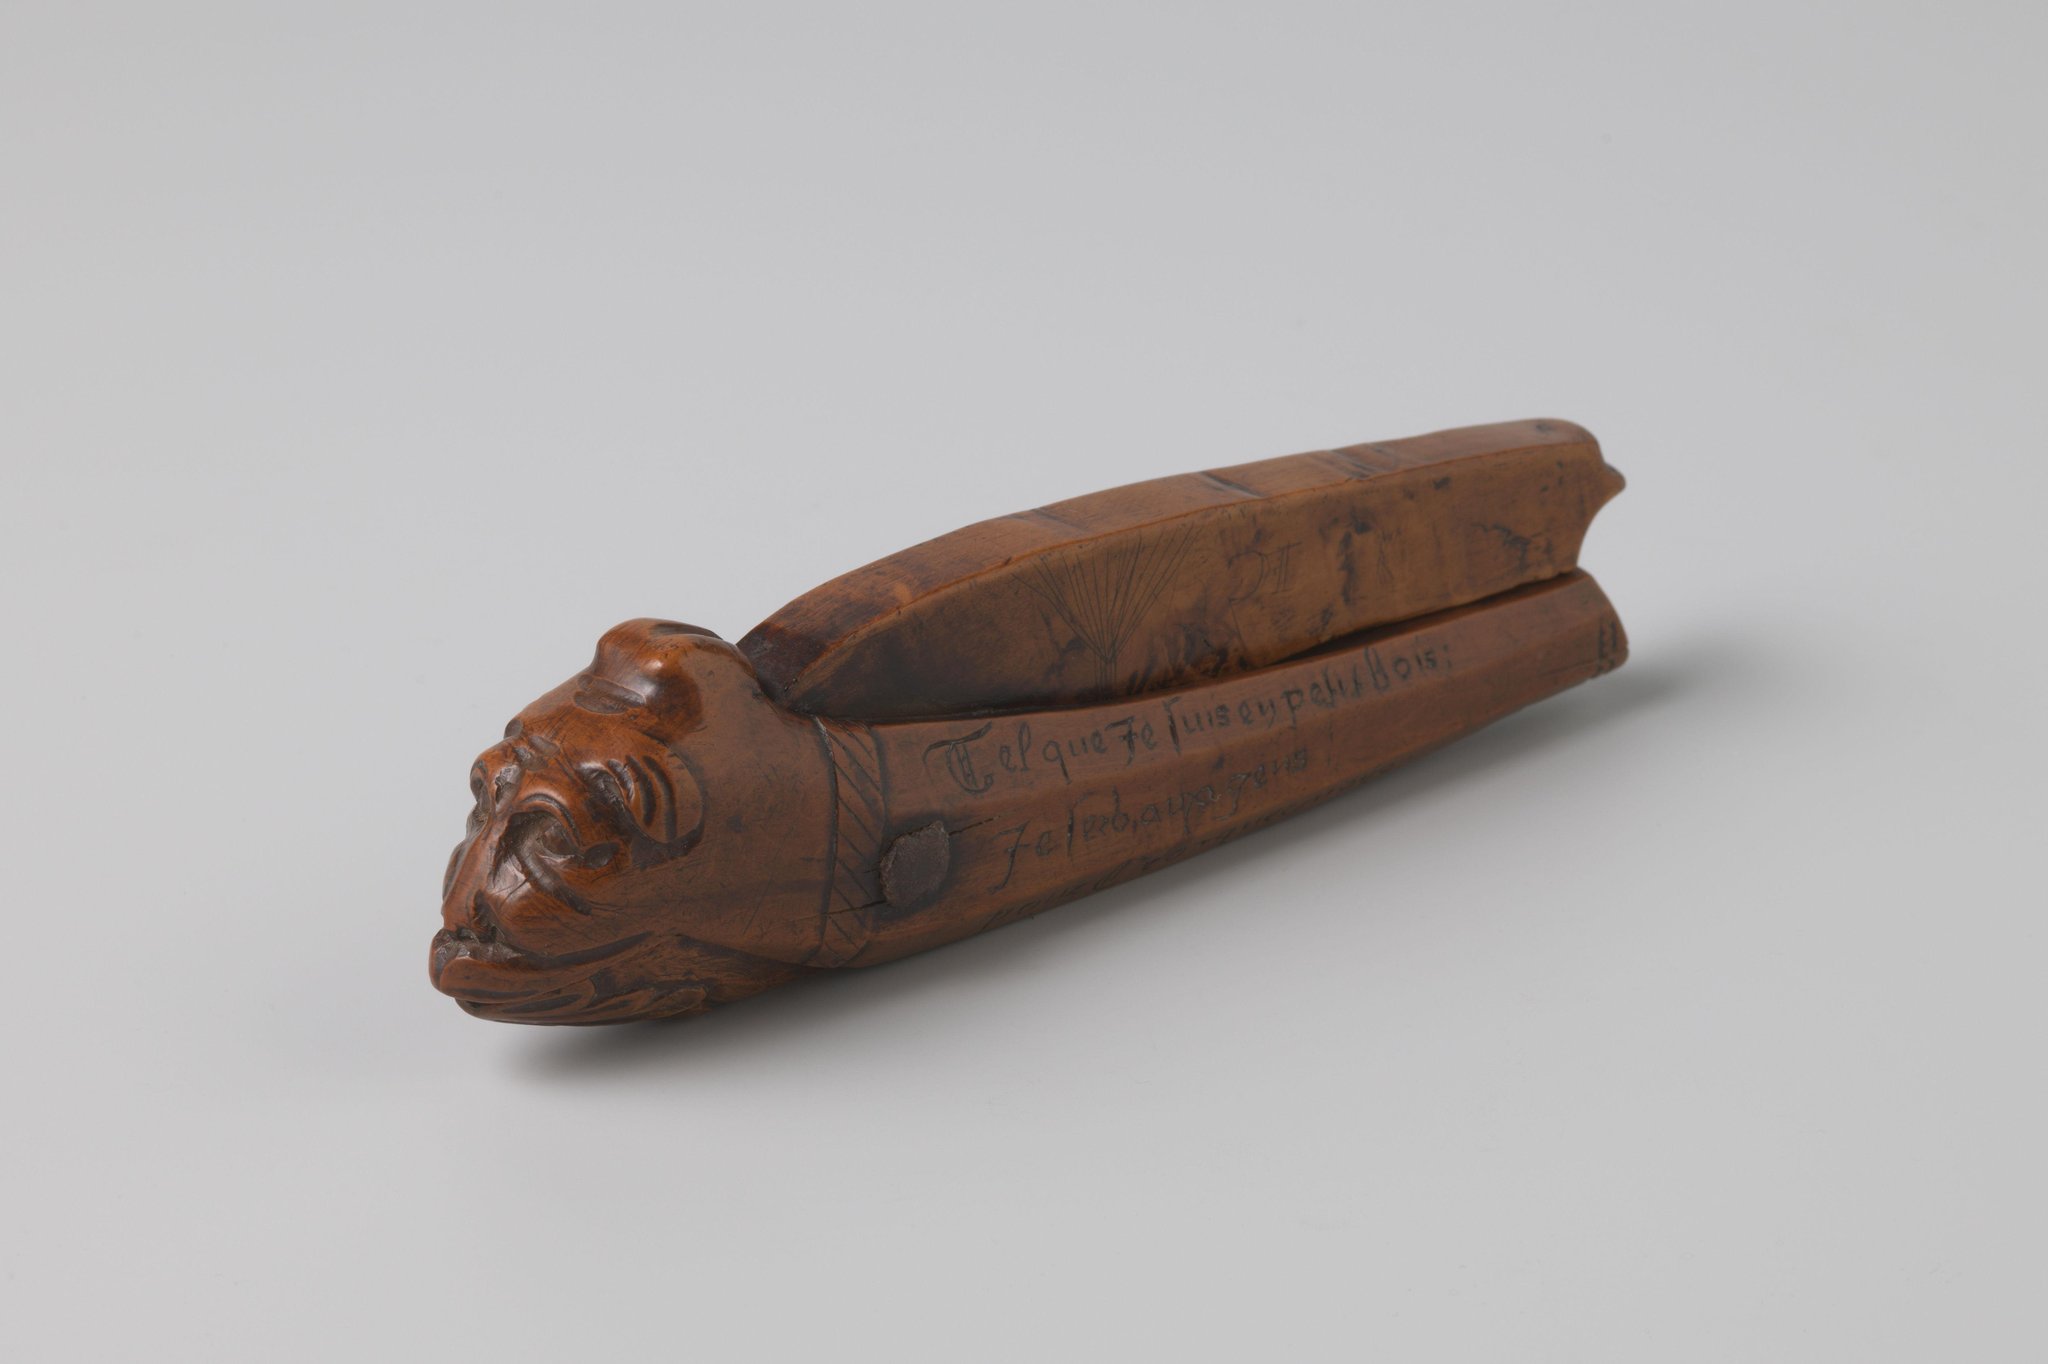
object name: nutcracker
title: Notenkraker van palmhout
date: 1583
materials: wood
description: Gesneden in de vorm van een beestenkop met inscriptie: Tout prend fin J. Kuirin 1583 Tel que je suis un petit bois Je sers aux gens Pour crocquer noix.